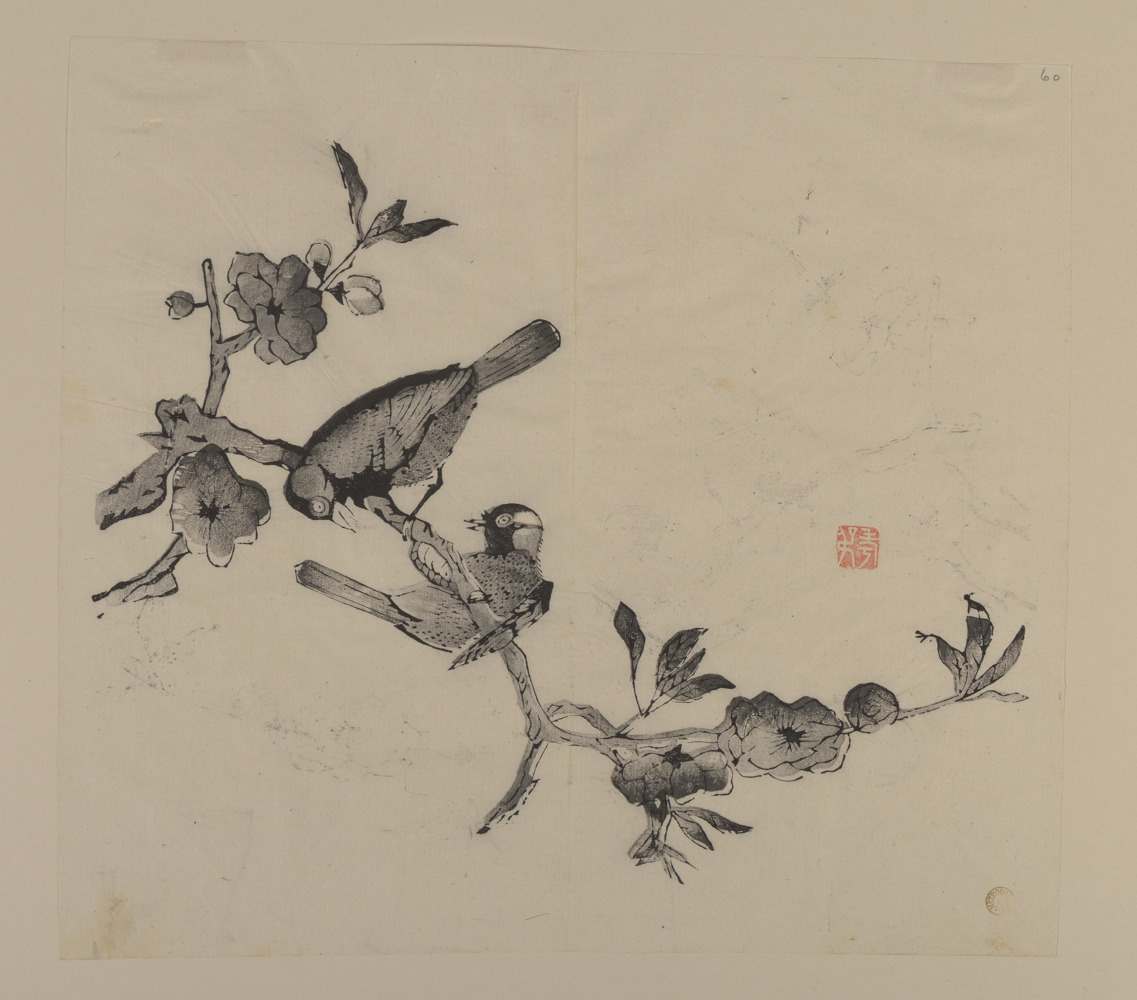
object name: print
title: Page from Shi Zhu Zhai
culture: chinese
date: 1736-1795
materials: ink, paper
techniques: polychrome, woodblock print